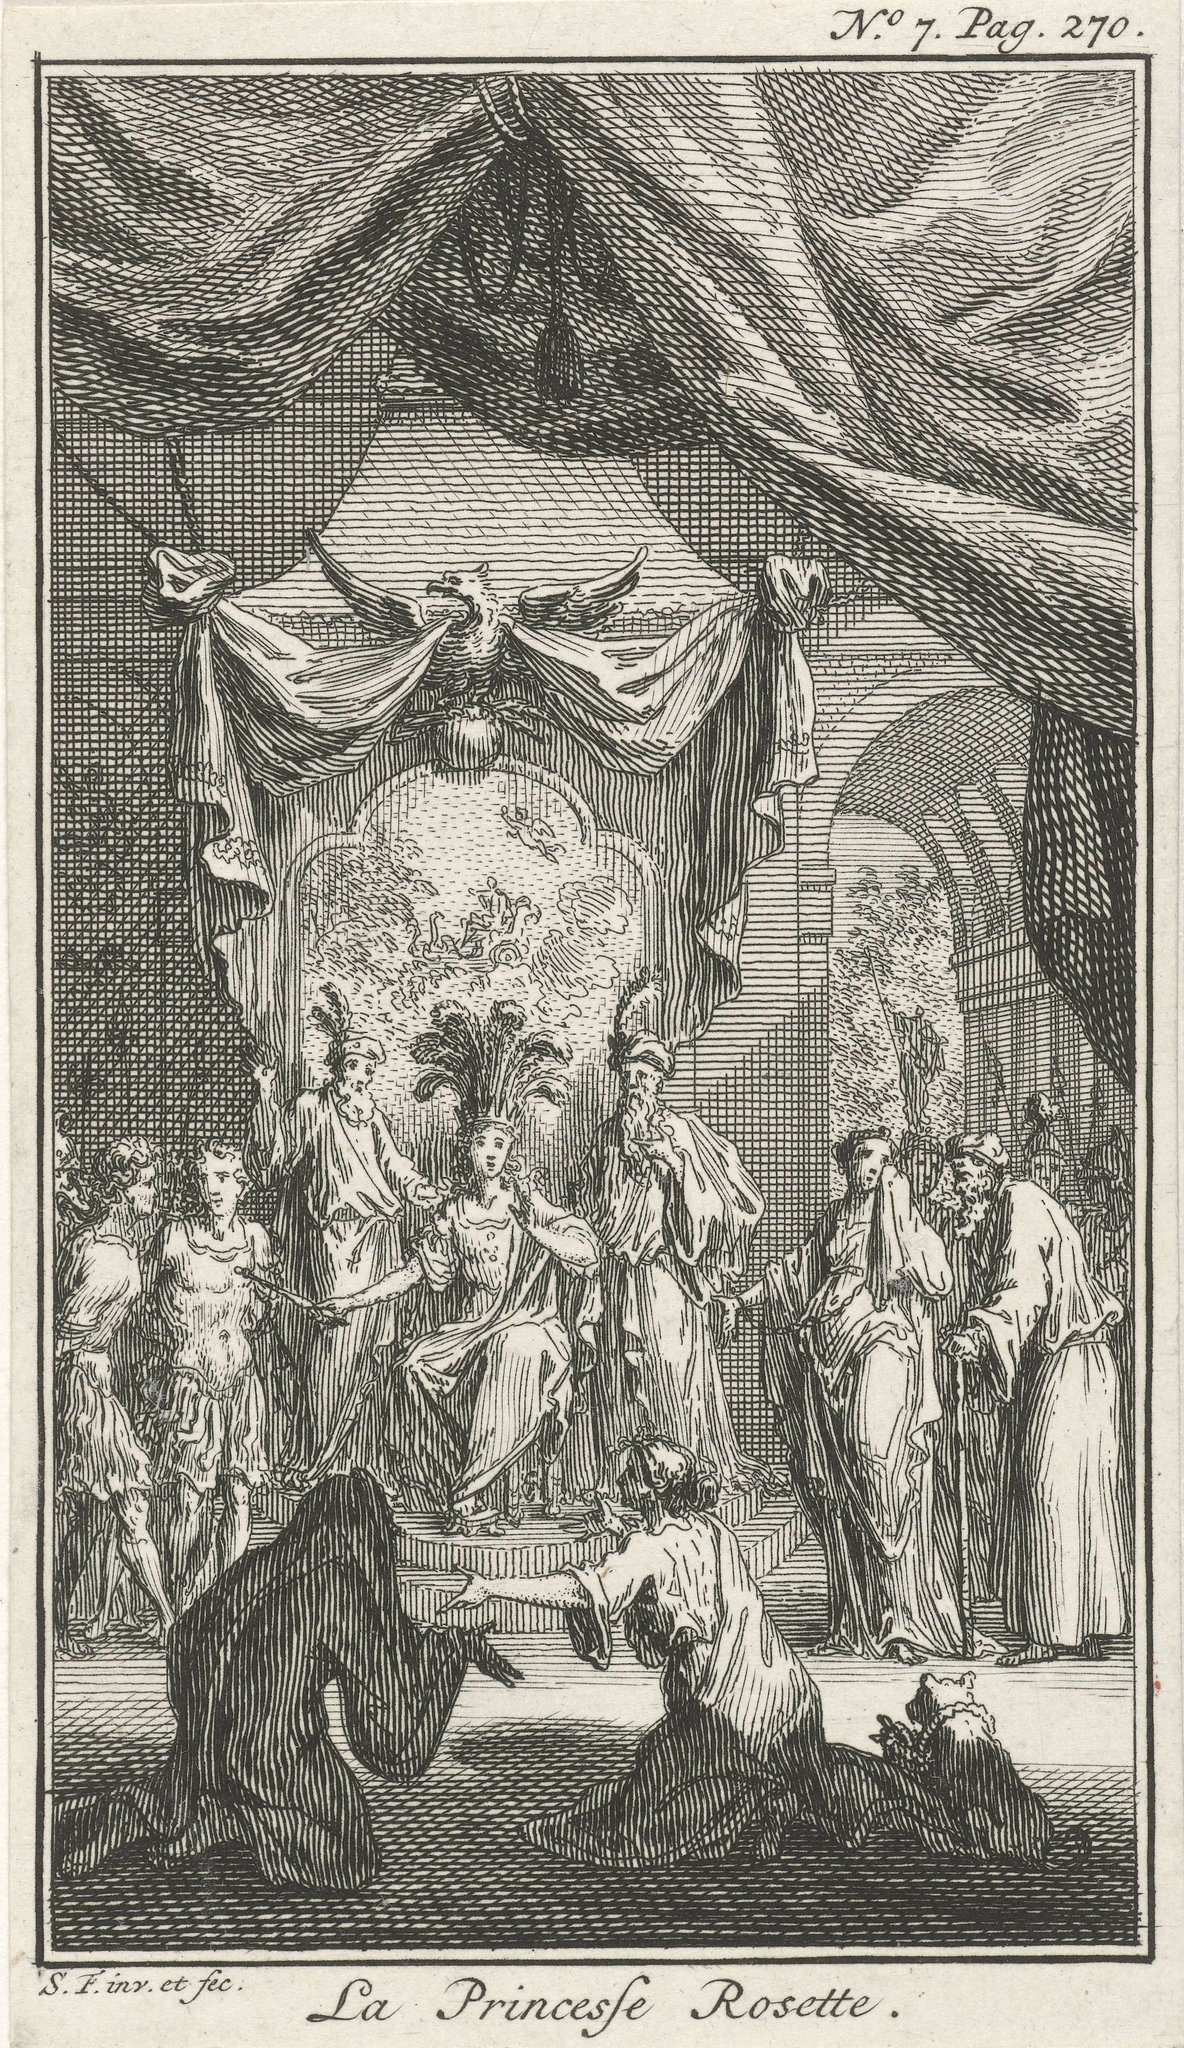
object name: print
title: La Princesse Rosette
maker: simon fokke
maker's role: draughtsman, print maker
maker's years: 1712-1784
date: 1722-1784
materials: paper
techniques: etching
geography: amsterdam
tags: king, handcuffs, kneeling on both knees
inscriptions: collector's mark: Lugt 240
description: Illustratie uit het sprookje La princesse Rosette van Mme d'Aulnoy. Twee figuren knielen voor een tronende koning wiens kroon getooid is met veren. De koning wordt geflankeerd door twee bebaarde mannen en houdt een scepter vast. Rechts voor hem staat een gehandboeide vrouw met zakdoek. Prent rechtsboven gemerkt: No. 7. Pag. 270.